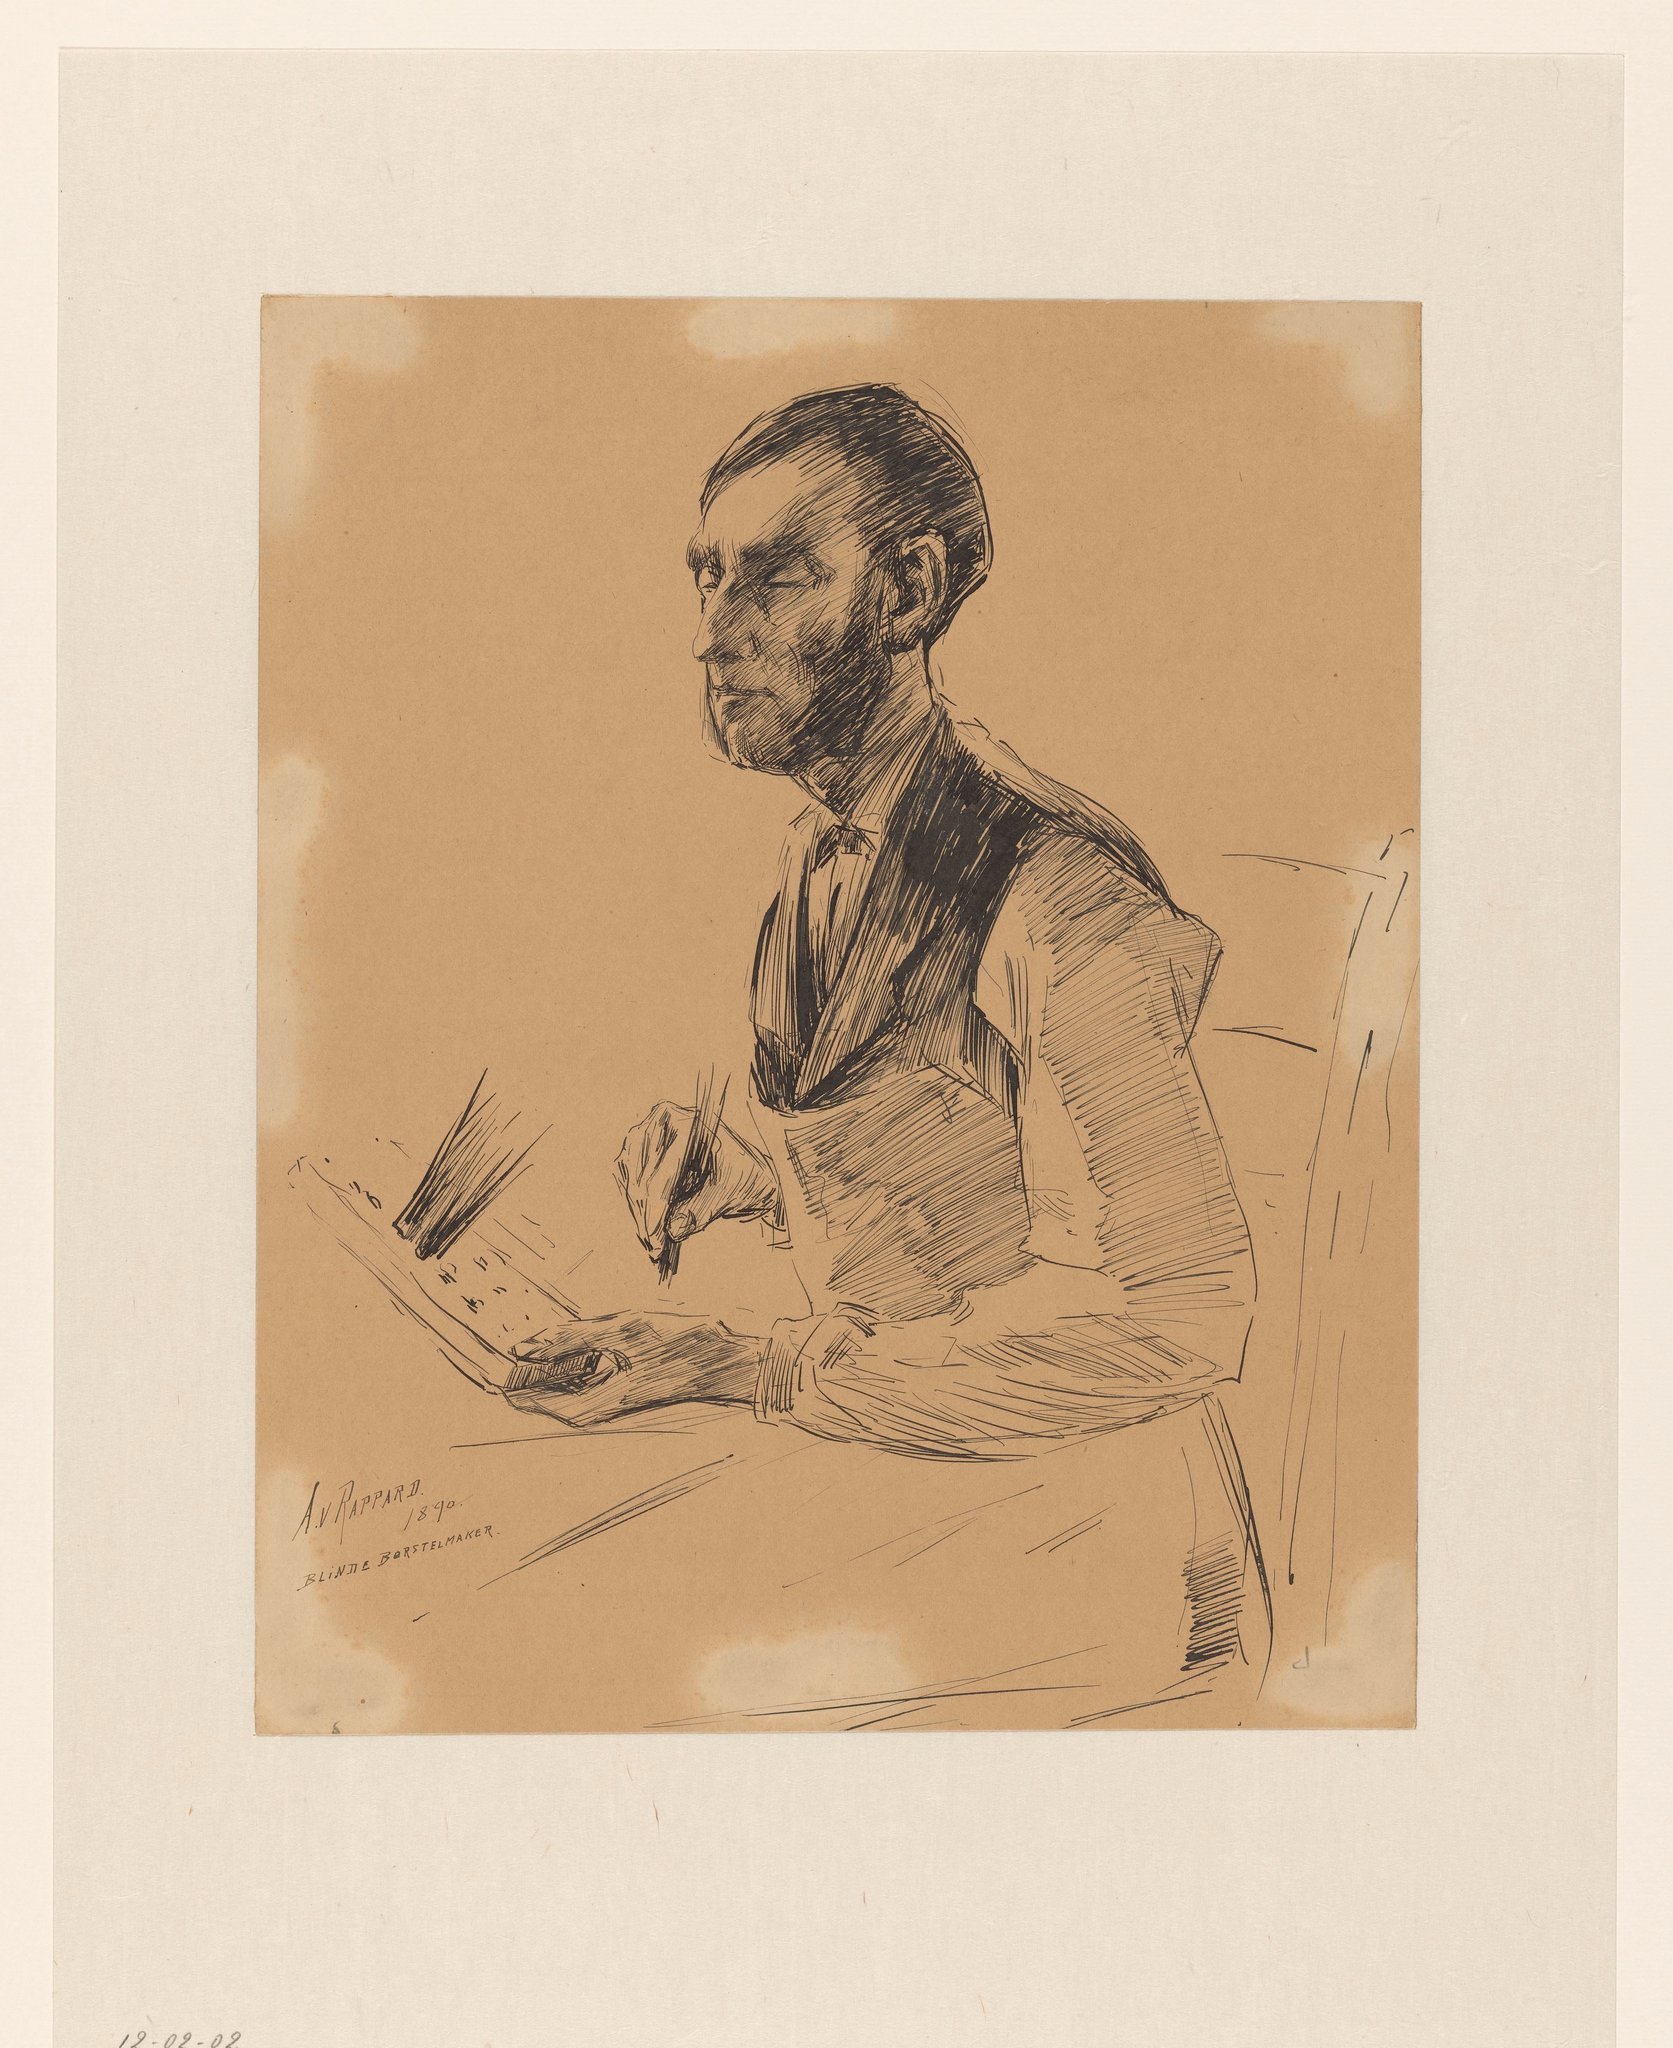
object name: drawing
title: Blinde borstelmaker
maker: anthon gerhard alexander van rappard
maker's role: draughtsman, print maker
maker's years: 1858-1892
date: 1890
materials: ink, paper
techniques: pen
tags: (household) utensils and implements (with name), handicrafts ~ other animal material, blind, blindness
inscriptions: date